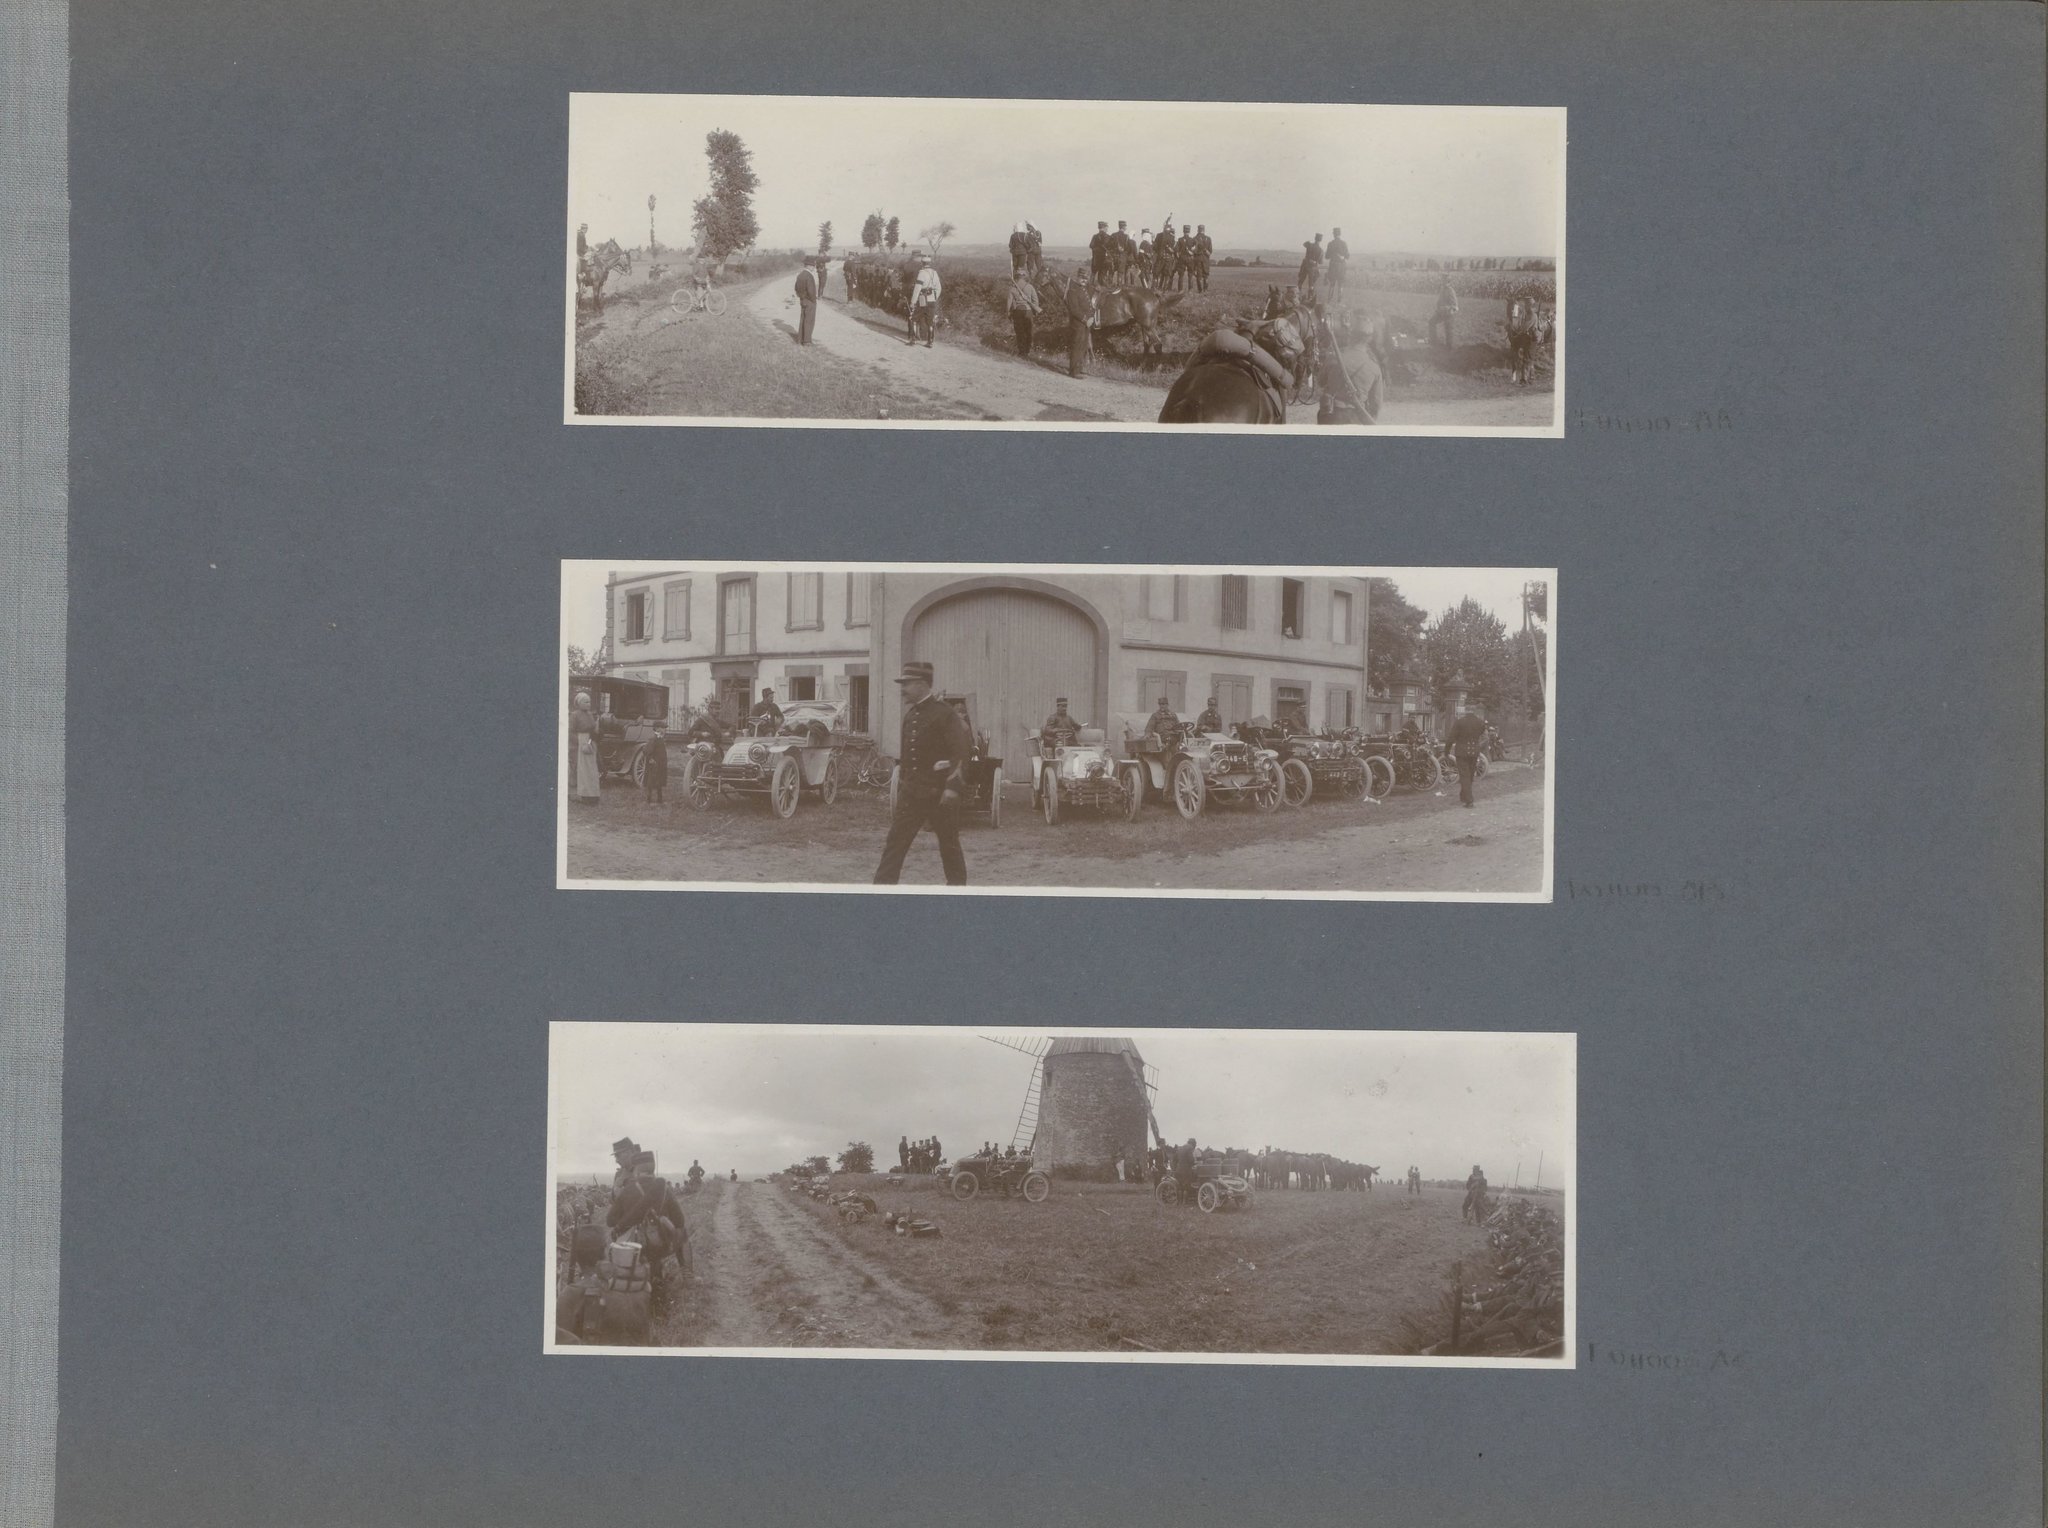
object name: album leaf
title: Militairen met paarden in de bocht van een weg in Frankrijk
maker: Anonymous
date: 1902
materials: paper, photographic support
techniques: daylight paper print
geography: france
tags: land forces, horse, france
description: Onderdeel van Fotoalbum van een legeroefening in Zuidwest-Frankrijk in 1902.